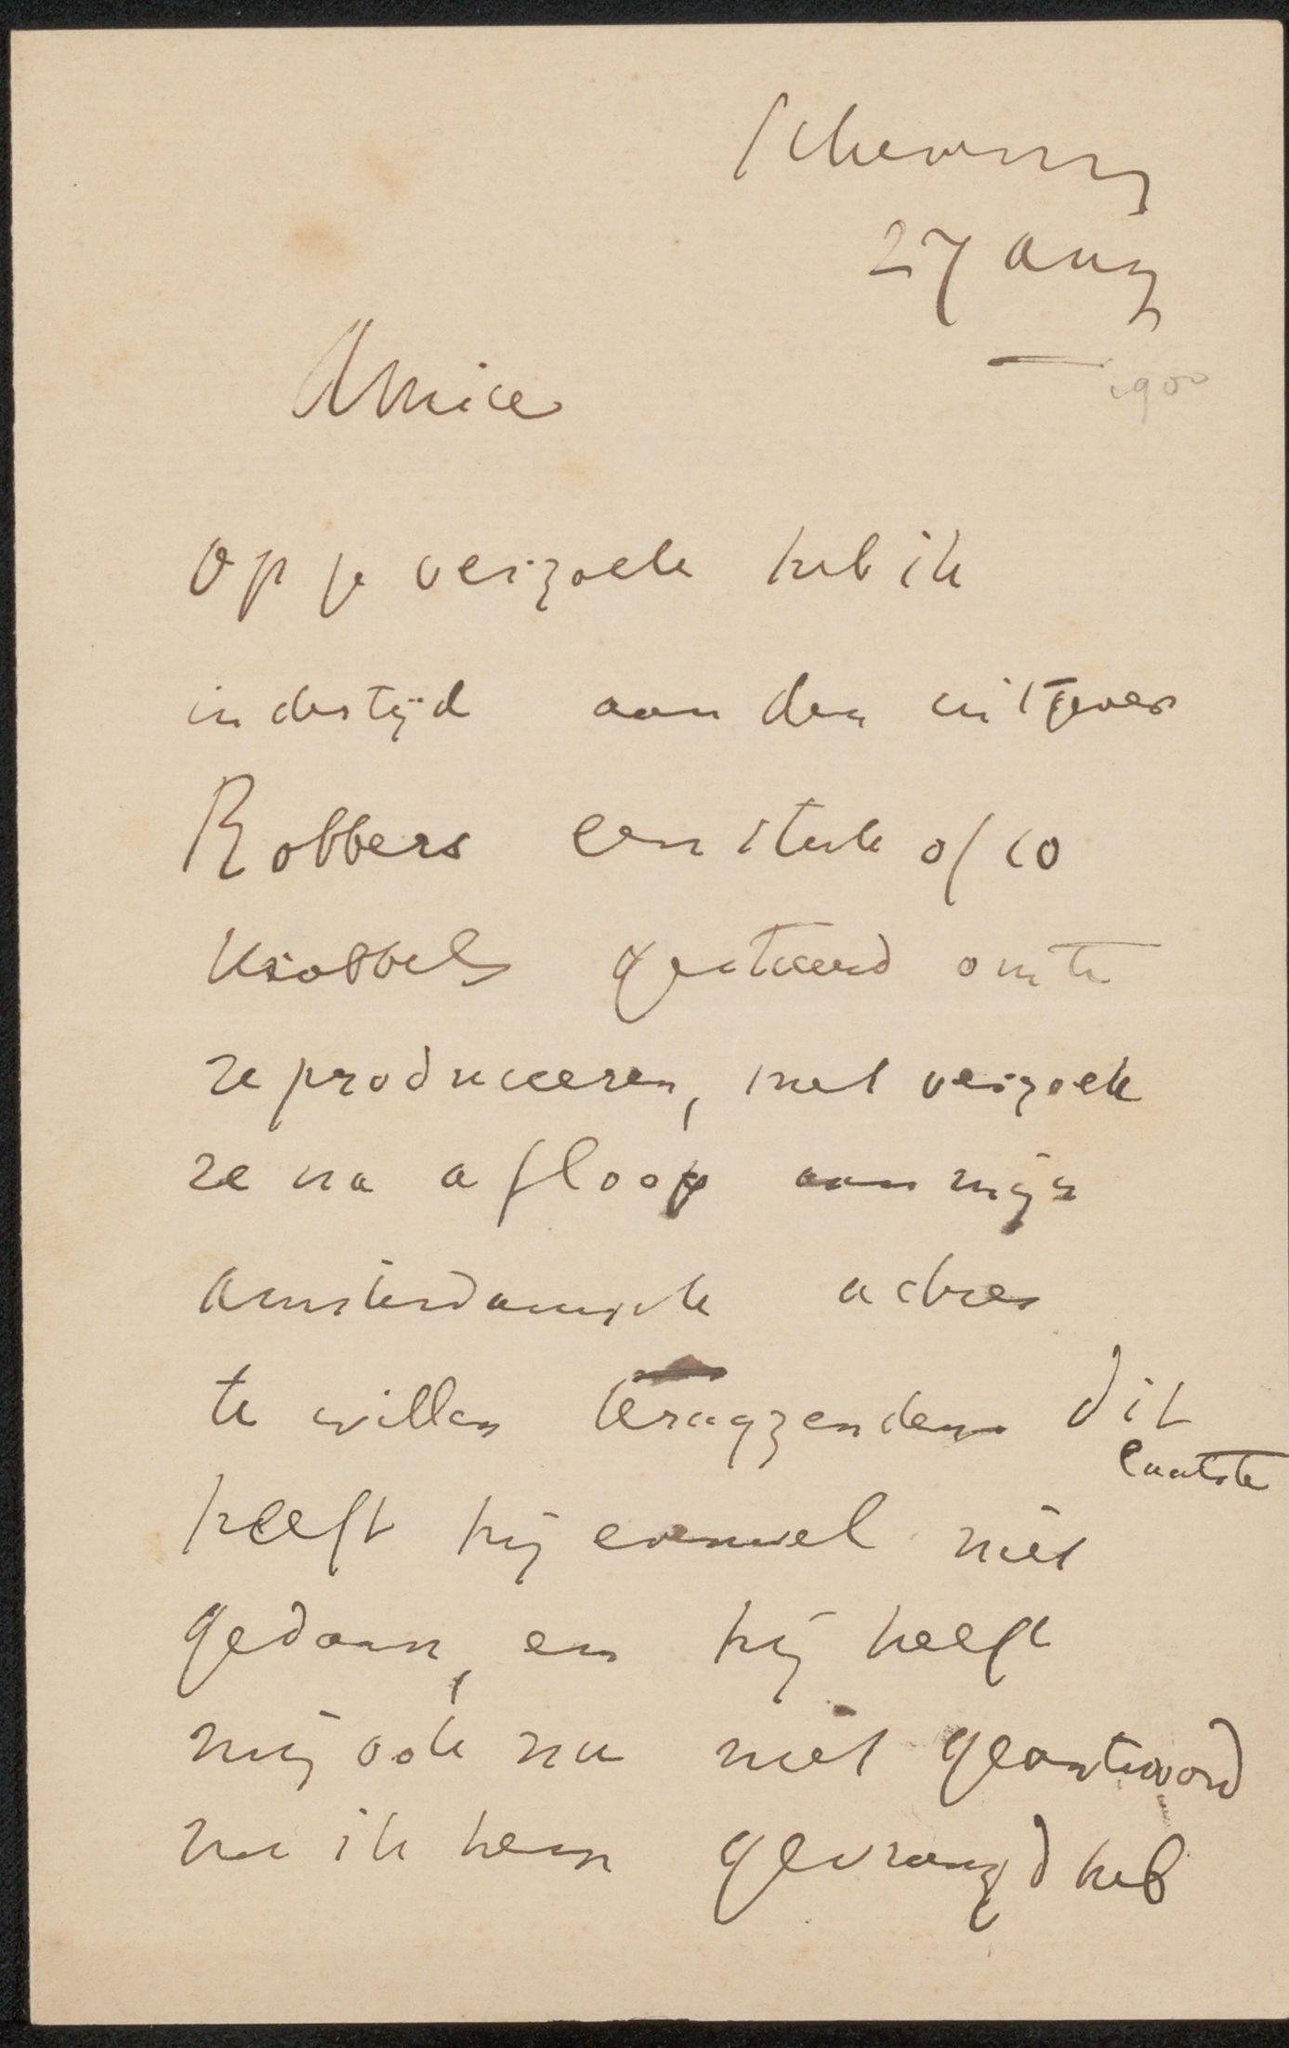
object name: letter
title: Brief aan Philip Zilcken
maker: isaac israels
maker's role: draughtsman, painter, print maker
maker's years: 1865-1934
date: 1900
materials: ink, paper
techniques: writing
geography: scheveningen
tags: herman robbers, philip zilcken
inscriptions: collector's mark: ‘RPK’